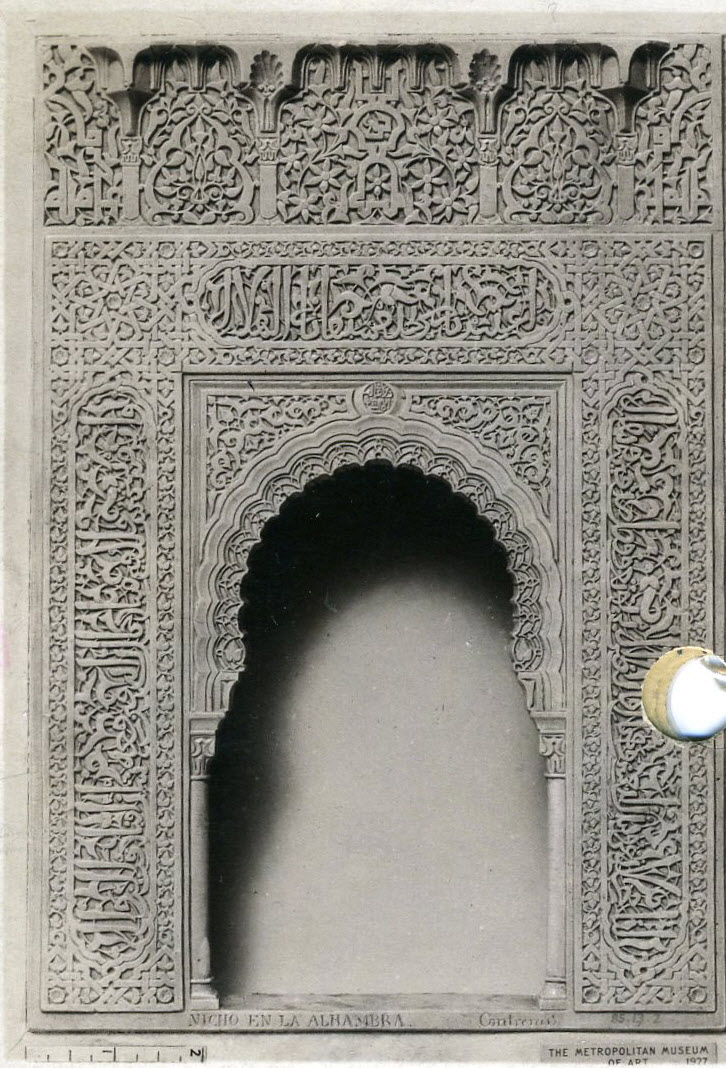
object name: architectural model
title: Architectural Model Based on the Alhambra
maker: rafael contreras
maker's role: artist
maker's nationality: spanish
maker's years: 1826-1890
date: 1801-1900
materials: plaster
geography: spain